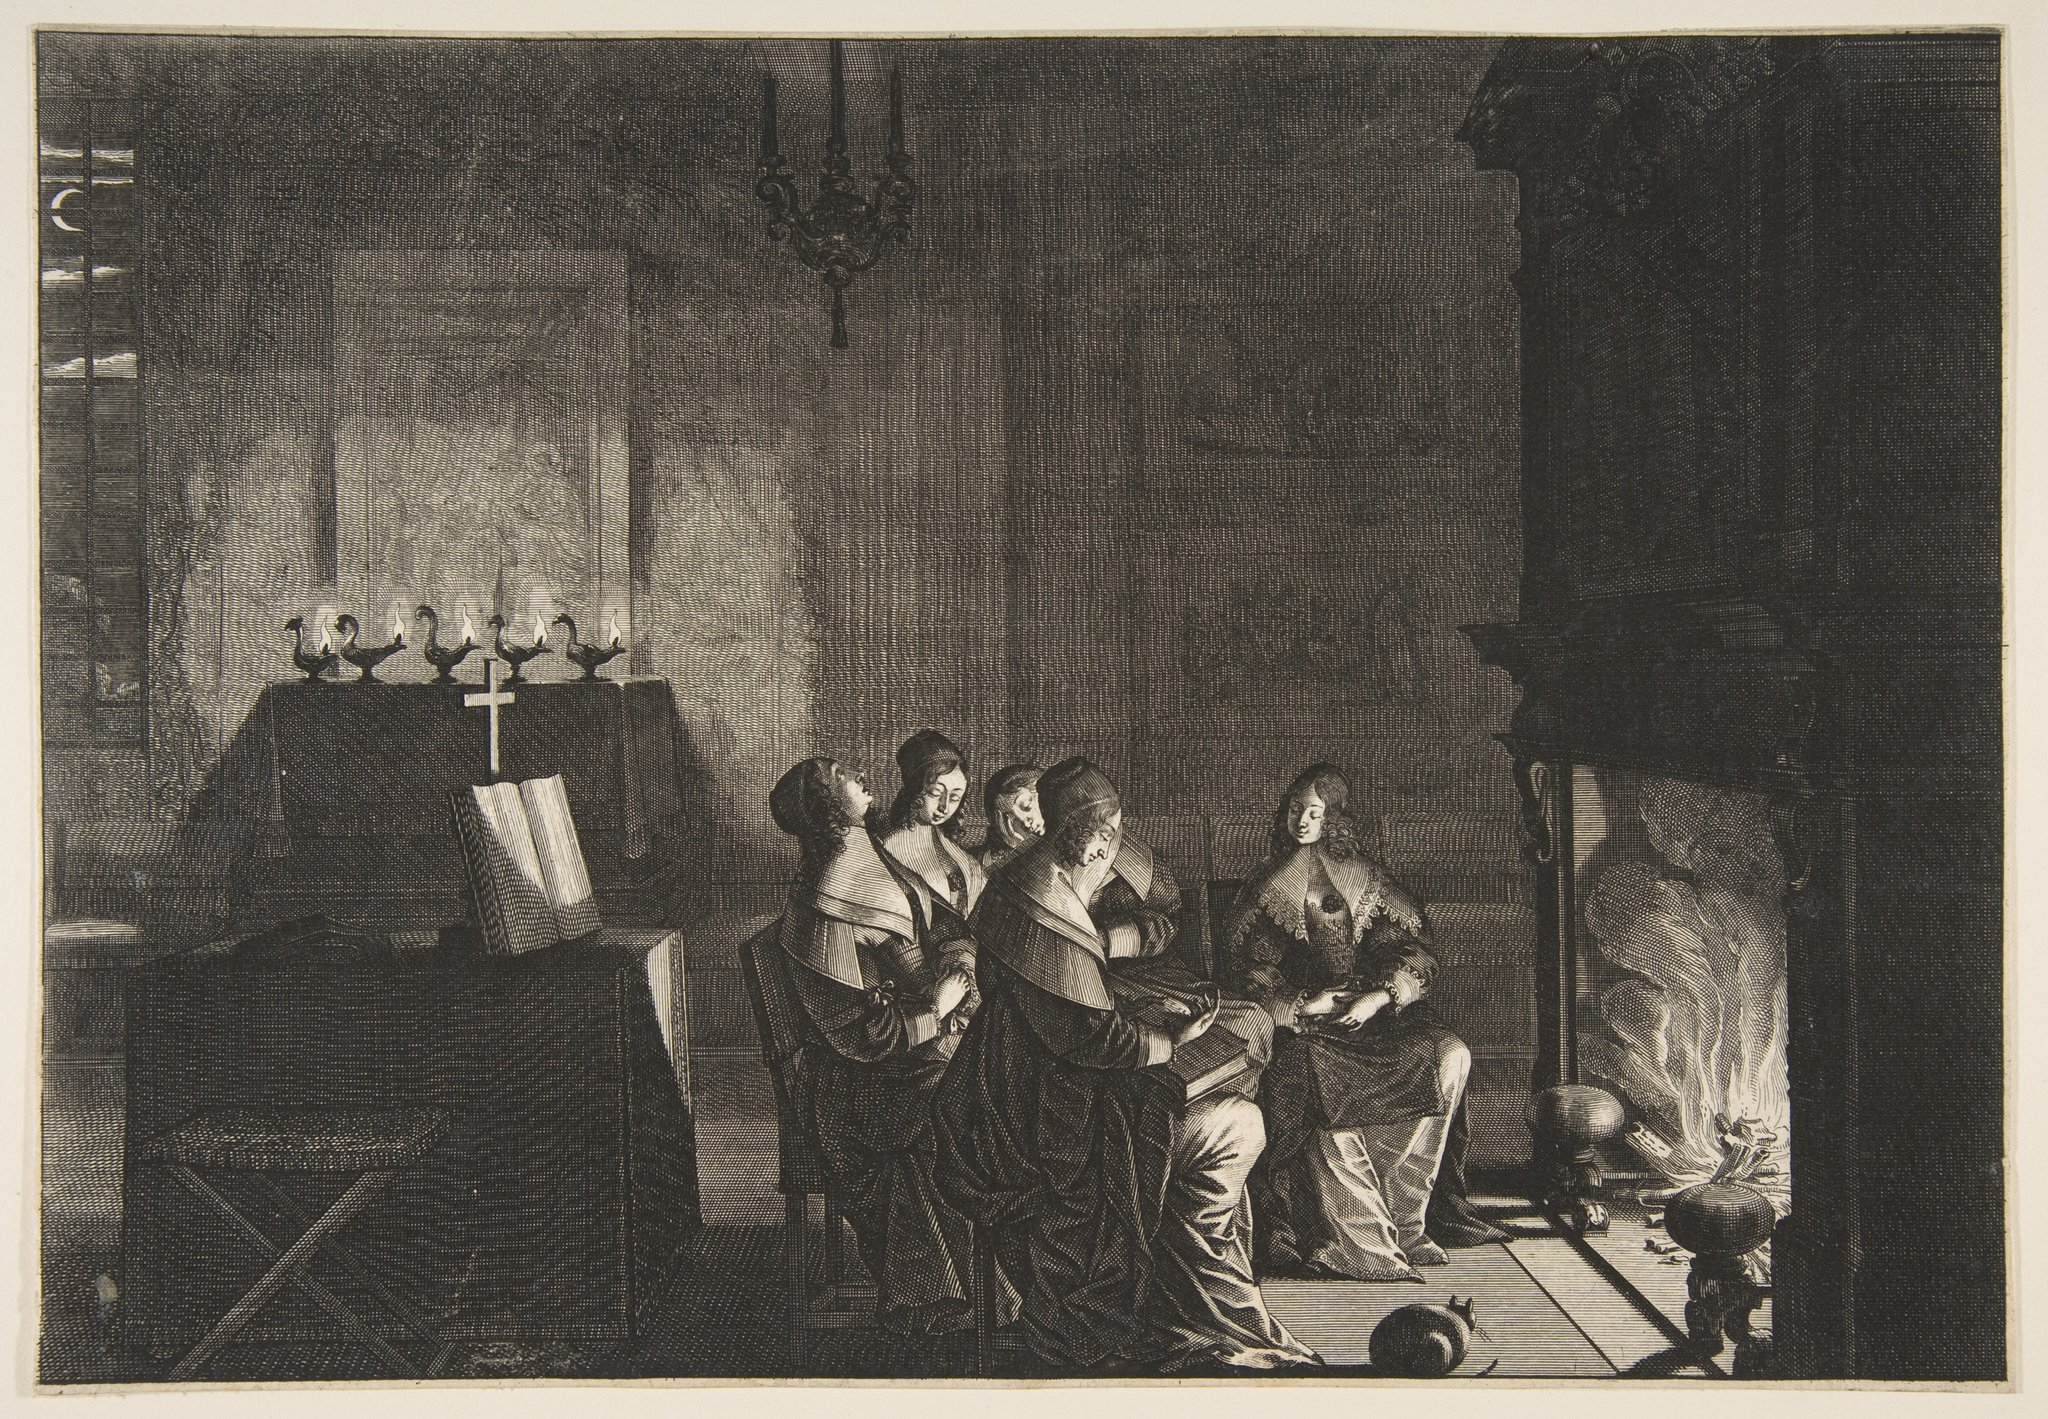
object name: print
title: Foolish Virgins Sleeping (Les Vierges folles somnolent en attendant l'arrivé de l"époux)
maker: abraham bosse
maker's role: artist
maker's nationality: french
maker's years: 1602-1676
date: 1635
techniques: etching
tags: fireplaces,sleeping,women